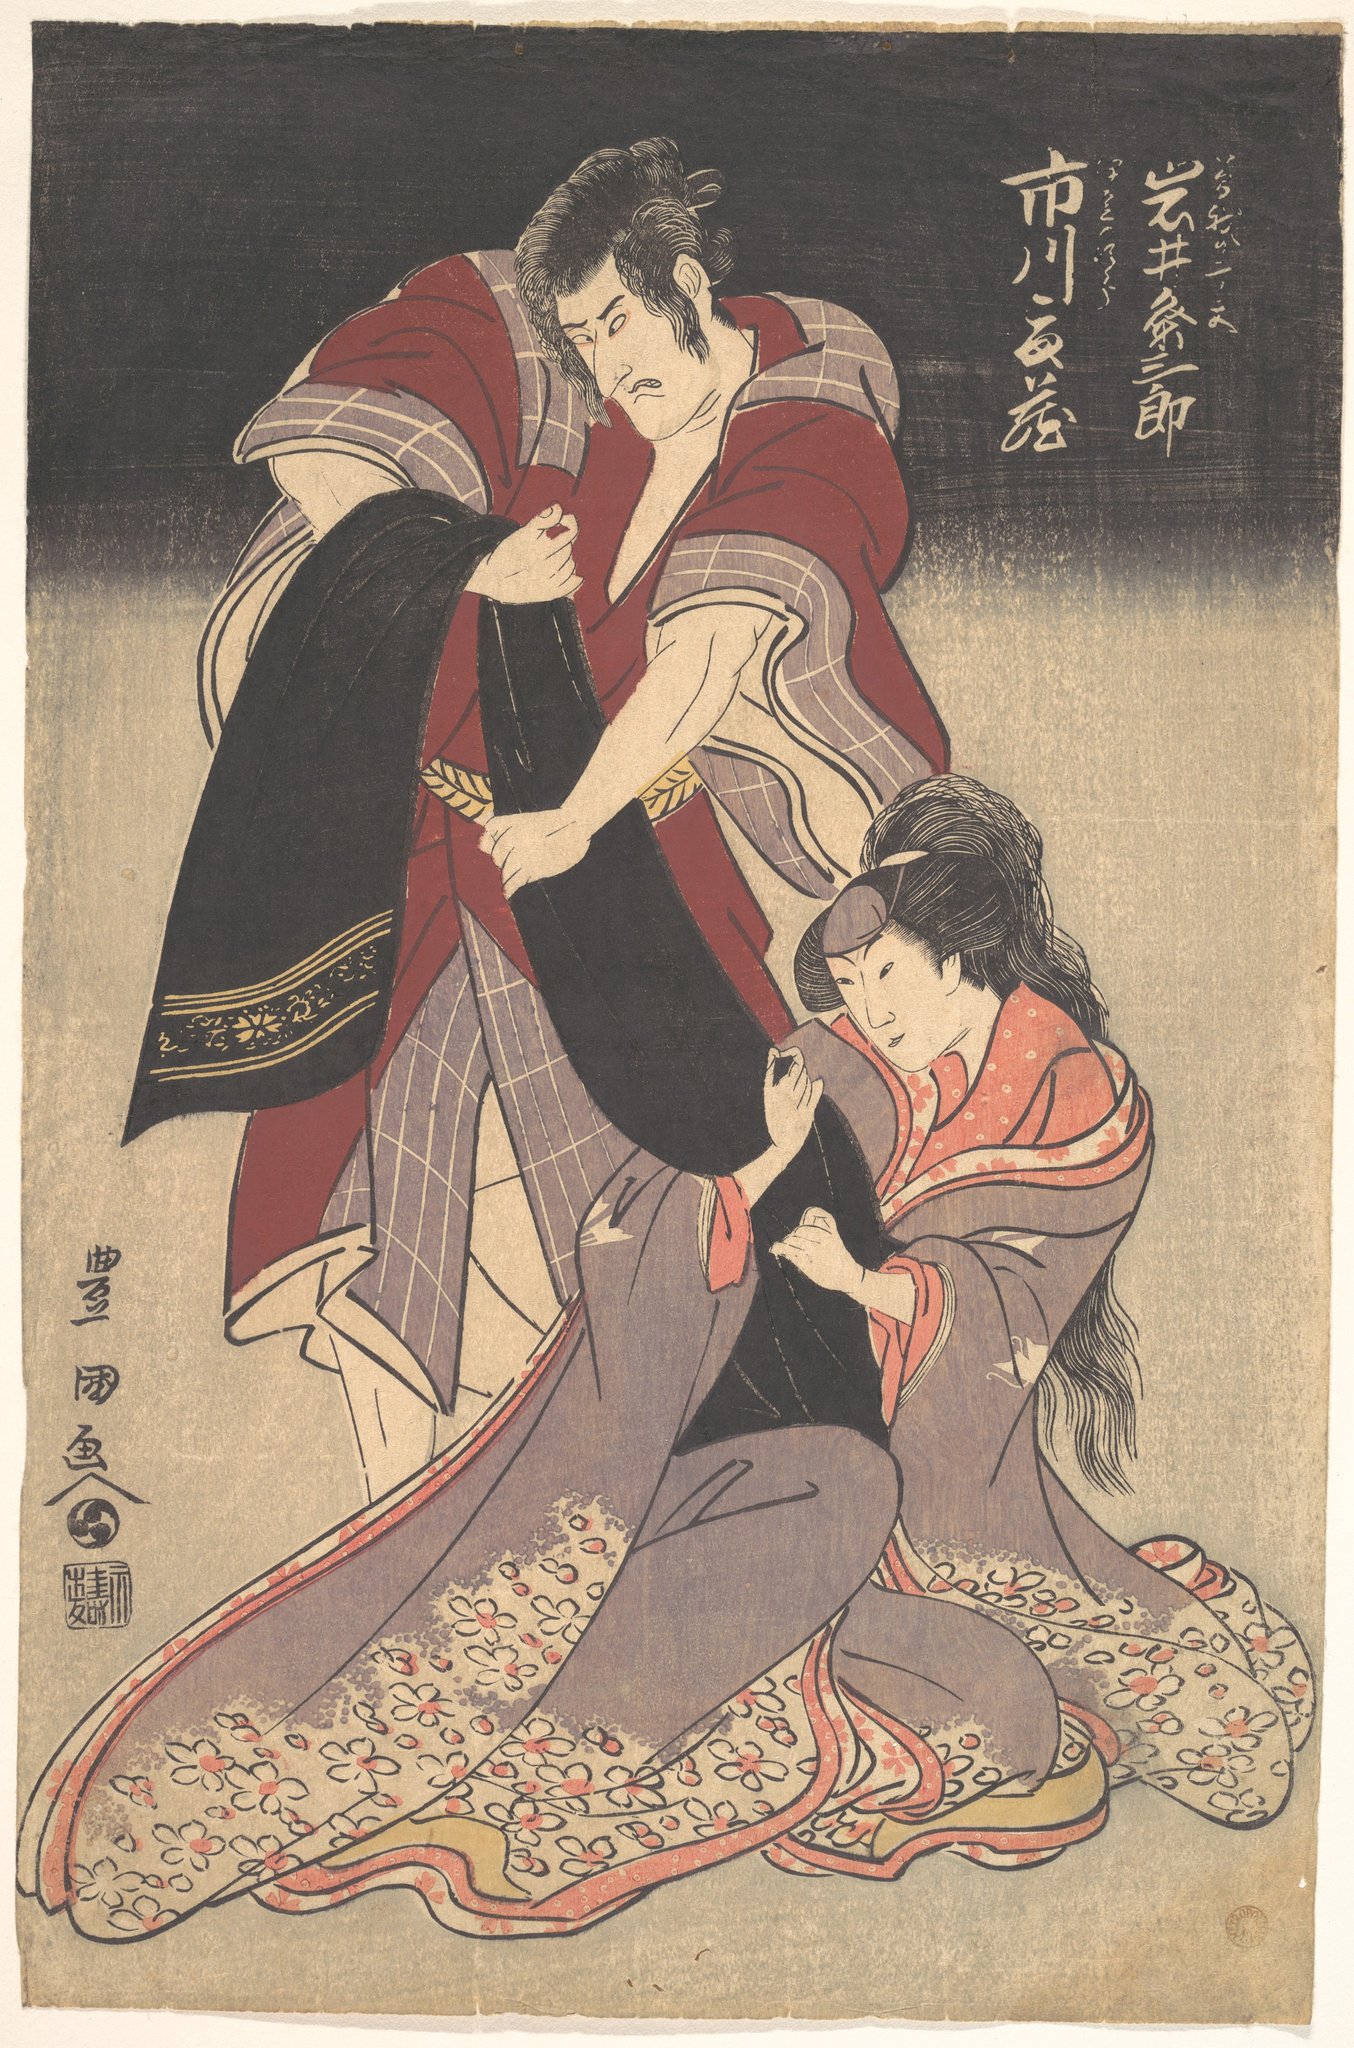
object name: woodblock print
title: Scene from a Drama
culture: japanese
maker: utagawa toyokuni i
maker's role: artist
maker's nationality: japanese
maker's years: 1769-1825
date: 1804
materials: ink, paper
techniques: woodblock print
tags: men,women